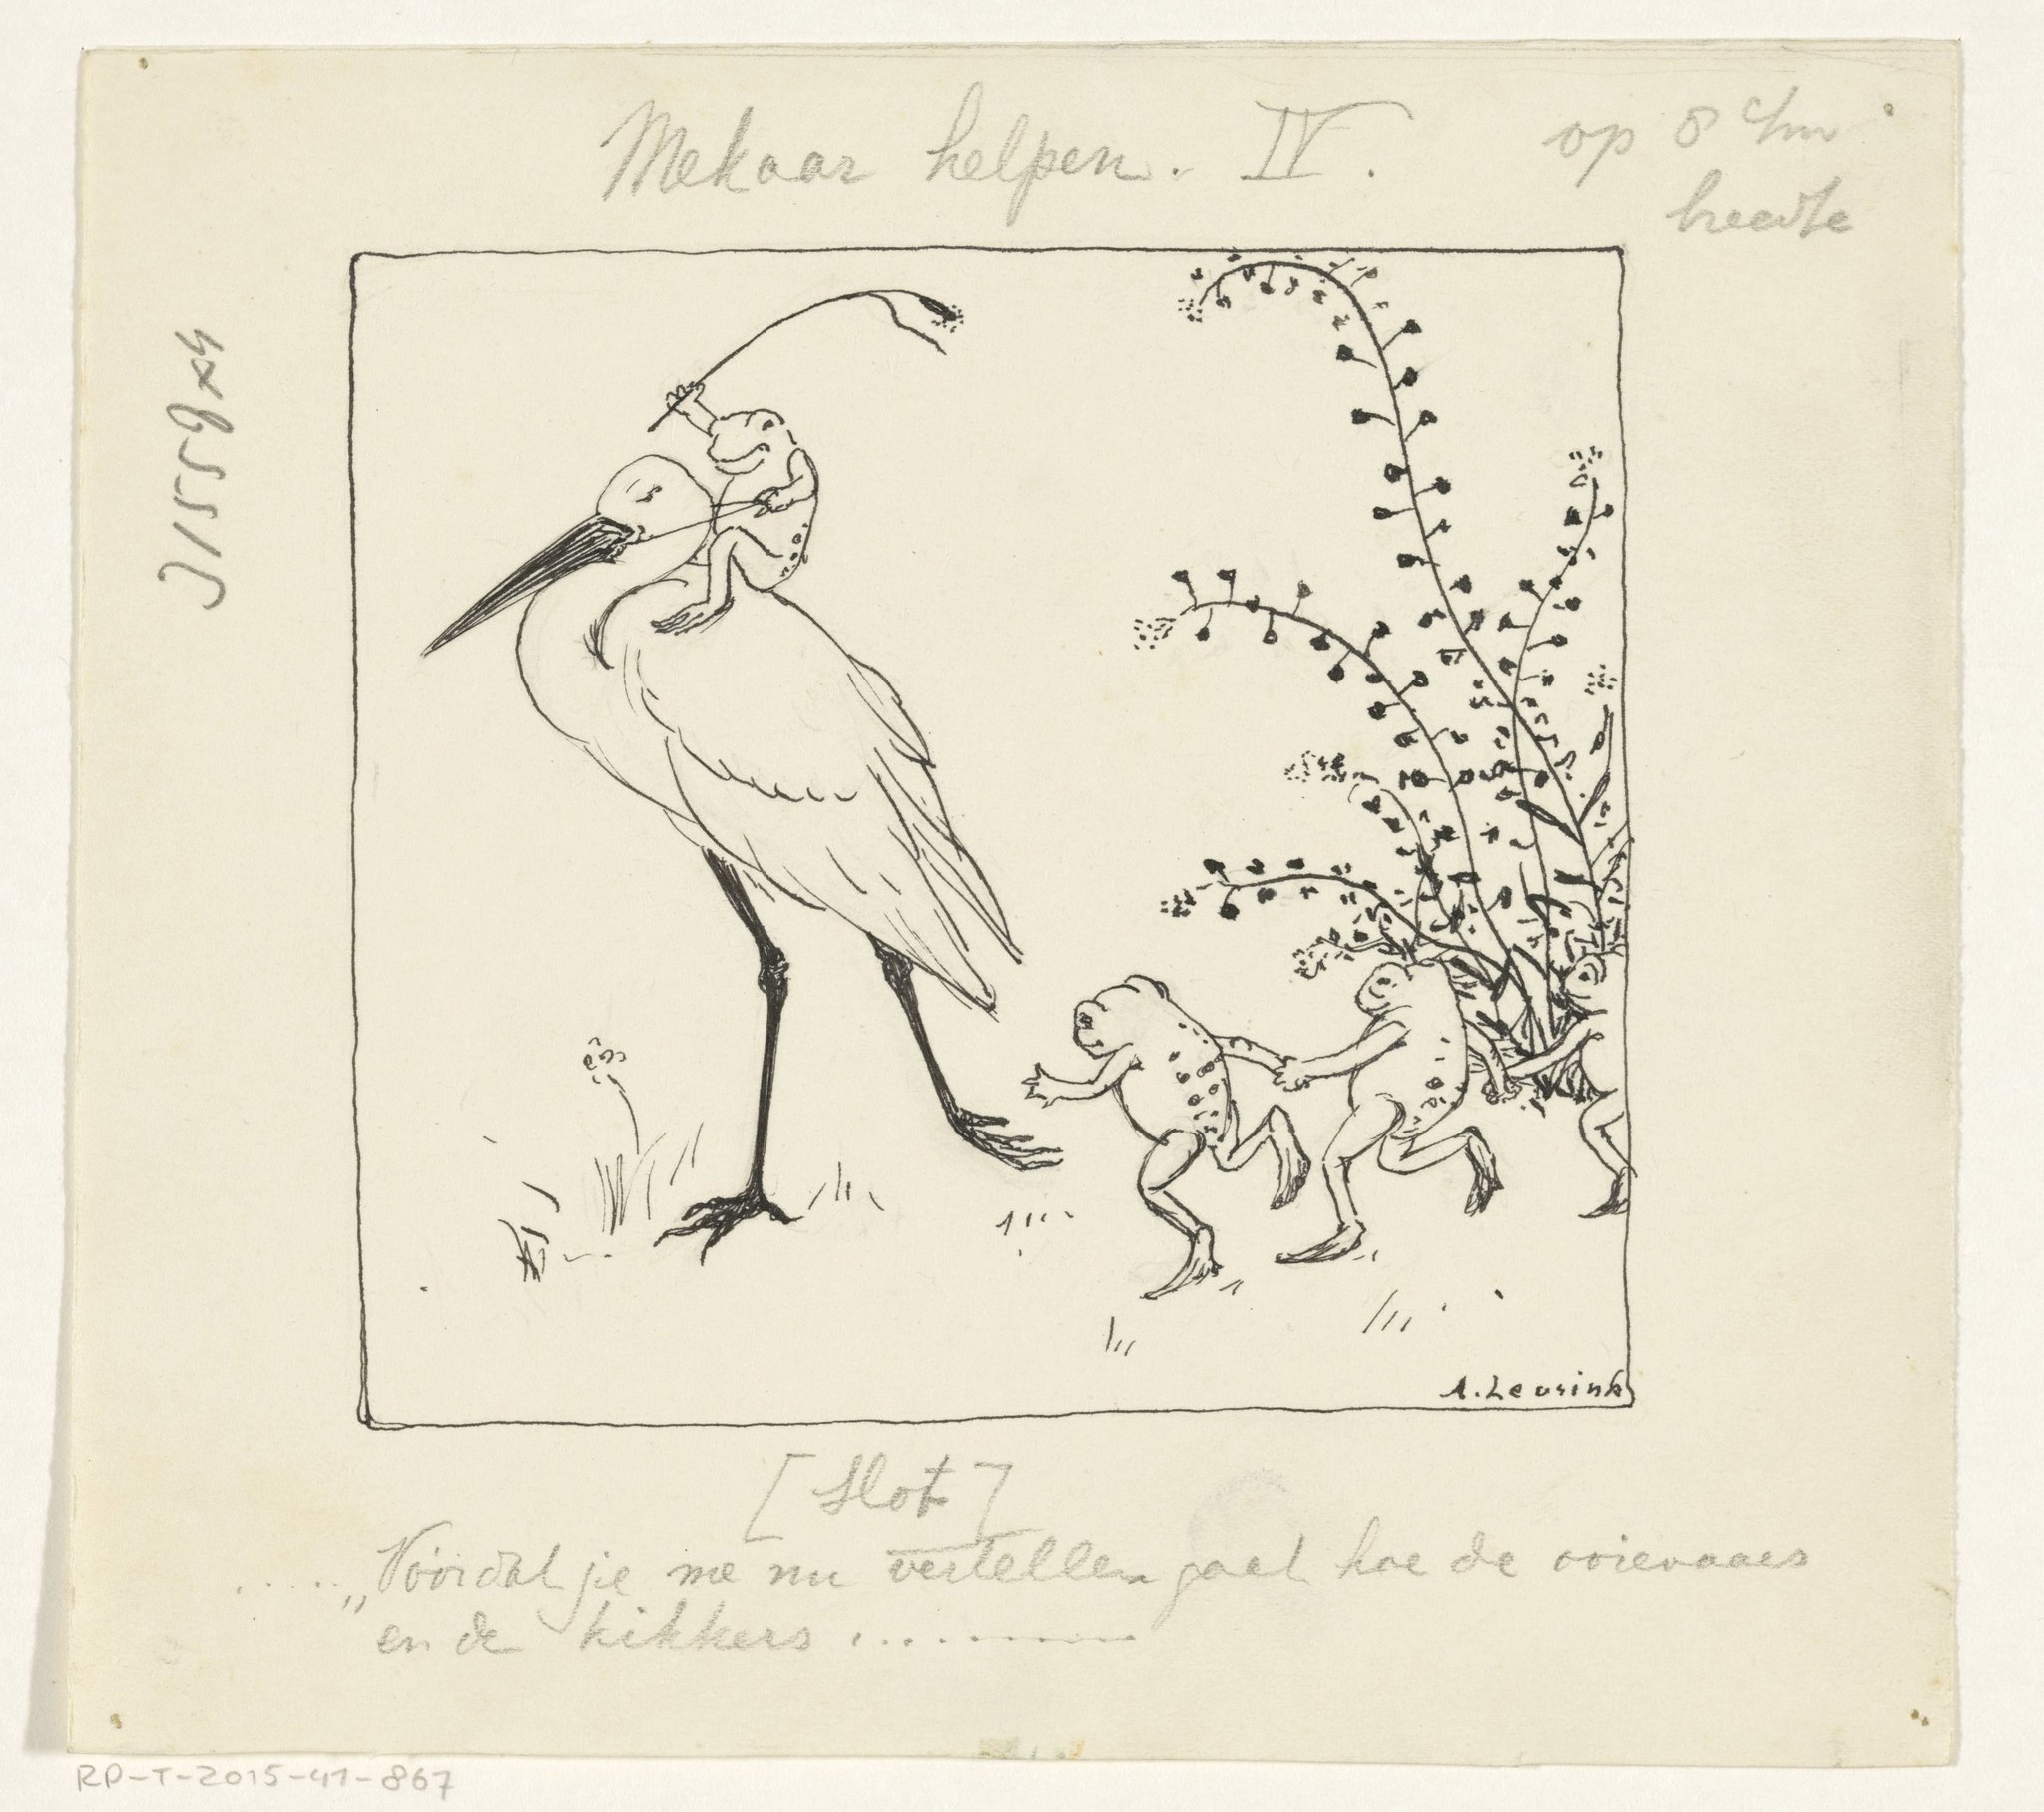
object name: drawing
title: Kikker rijdend op een ooievaar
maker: anny leusink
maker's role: draughtsman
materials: ink, paper, pencil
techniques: pen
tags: tailless amphibians: frog, shore-birds and wading-birds: stork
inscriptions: signature: ‘A. Leusink’, collector's mark: Lugt 2228, annotation: ‘Mekaar helpen. IV./ [slot]/ ...."Voordat je me nu vertellen gaat hoe de ooievaars/ en de kikkers .......’, :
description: Een kikker berijdt een ooievaar en houdt een teugel en een takje vast. Op de grond lopen drie kikkers hand in hand.